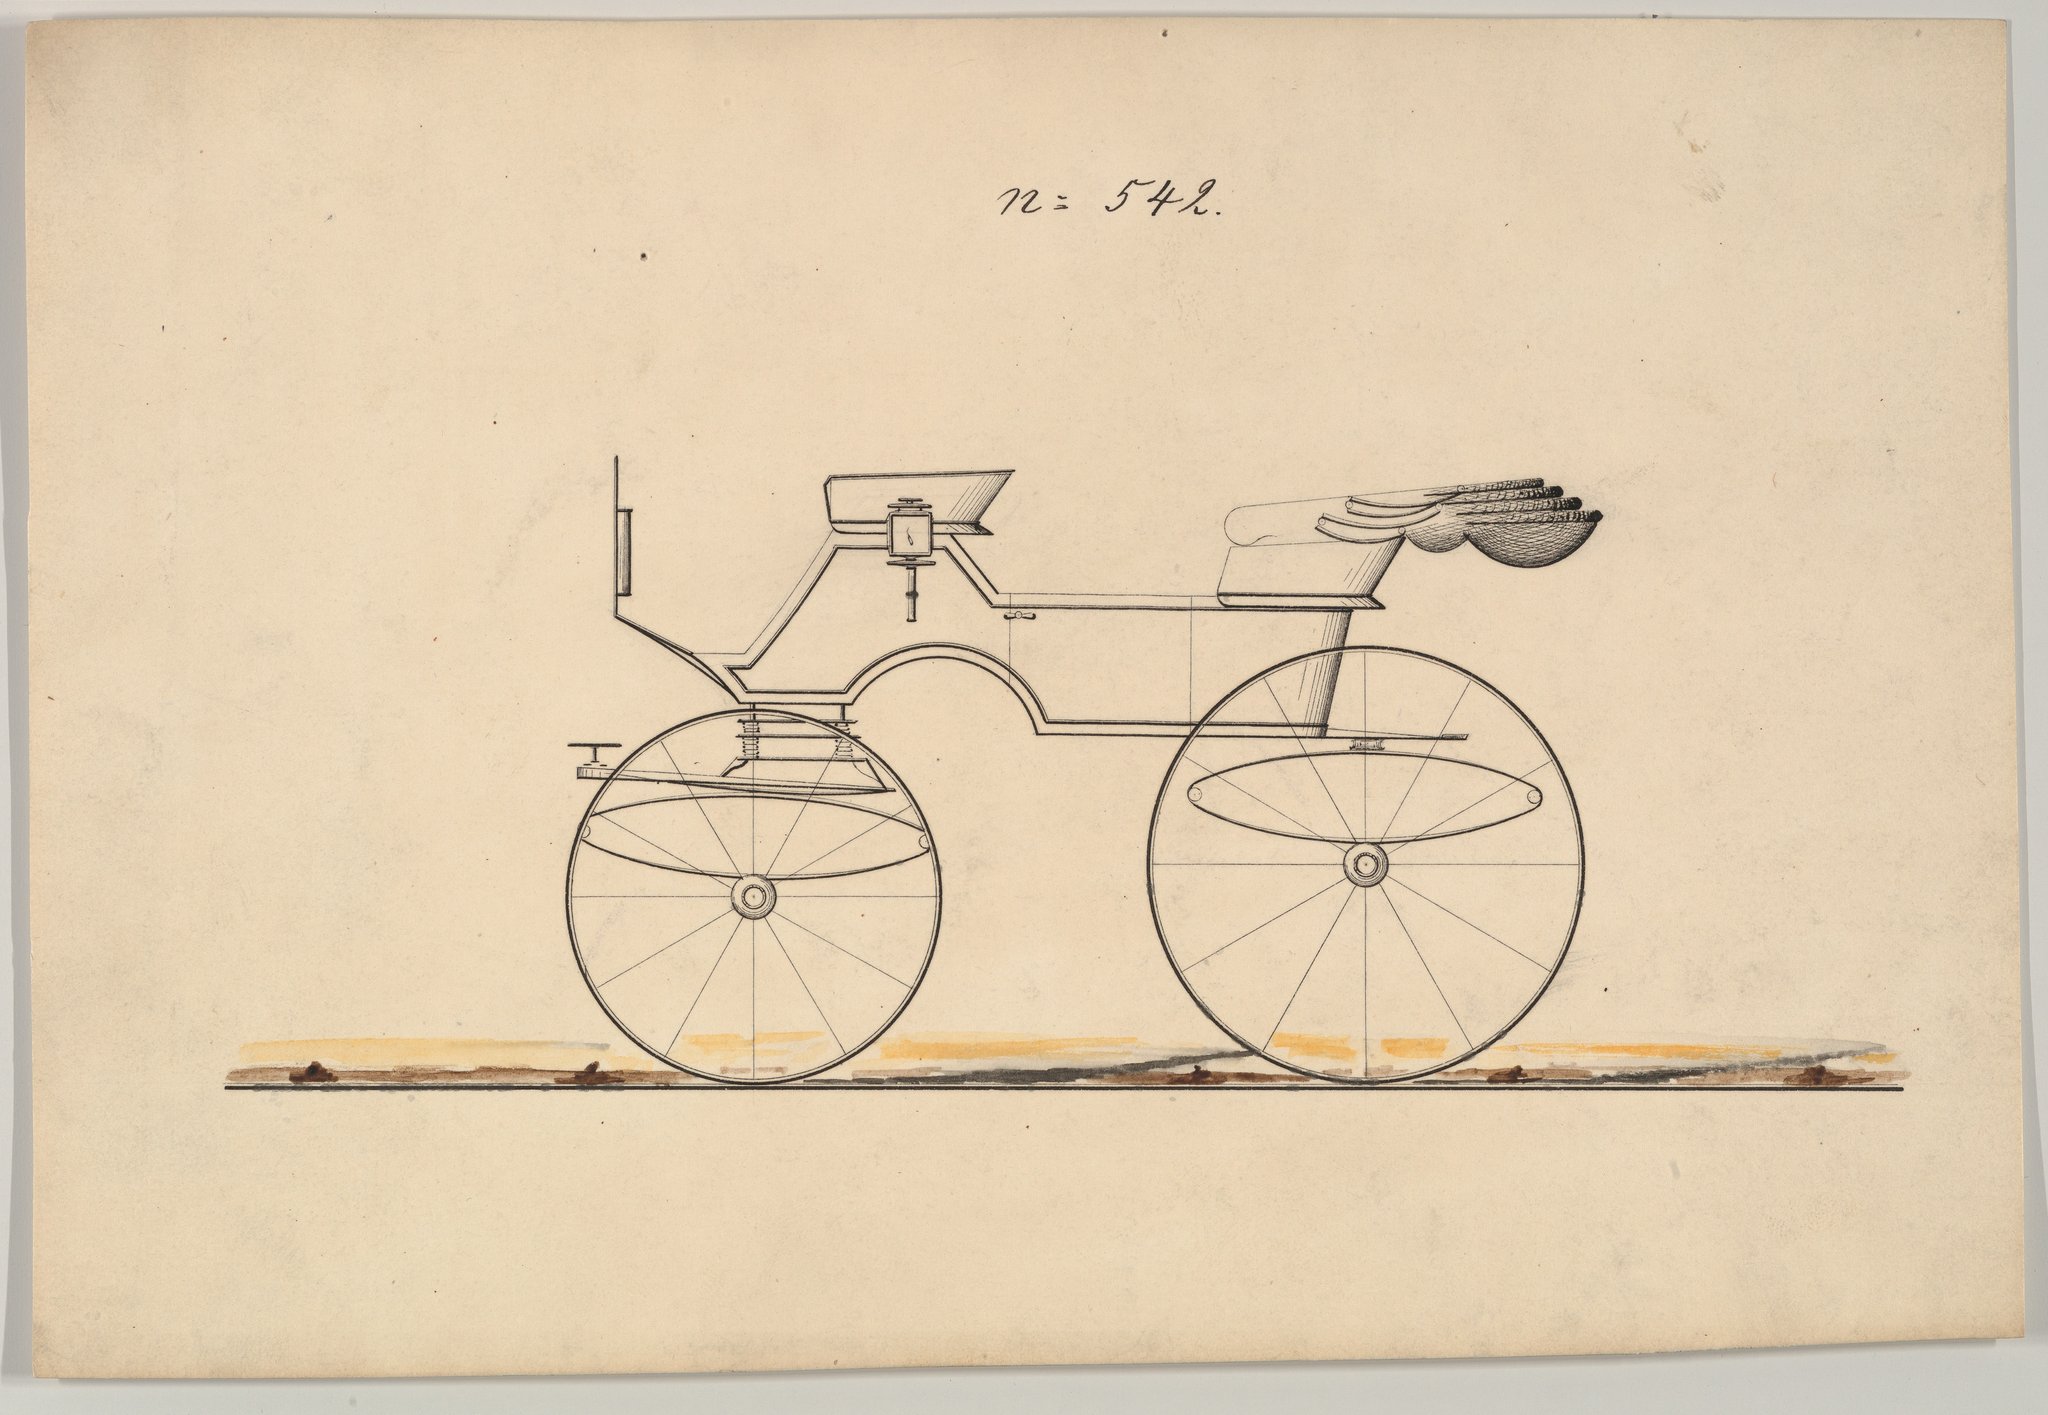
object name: drawing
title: Design for Phaeton, no. 542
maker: brewster & co.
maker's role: manufacturer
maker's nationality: american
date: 1850-1874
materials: gouache, ink, watercolor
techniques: pen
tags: carriages